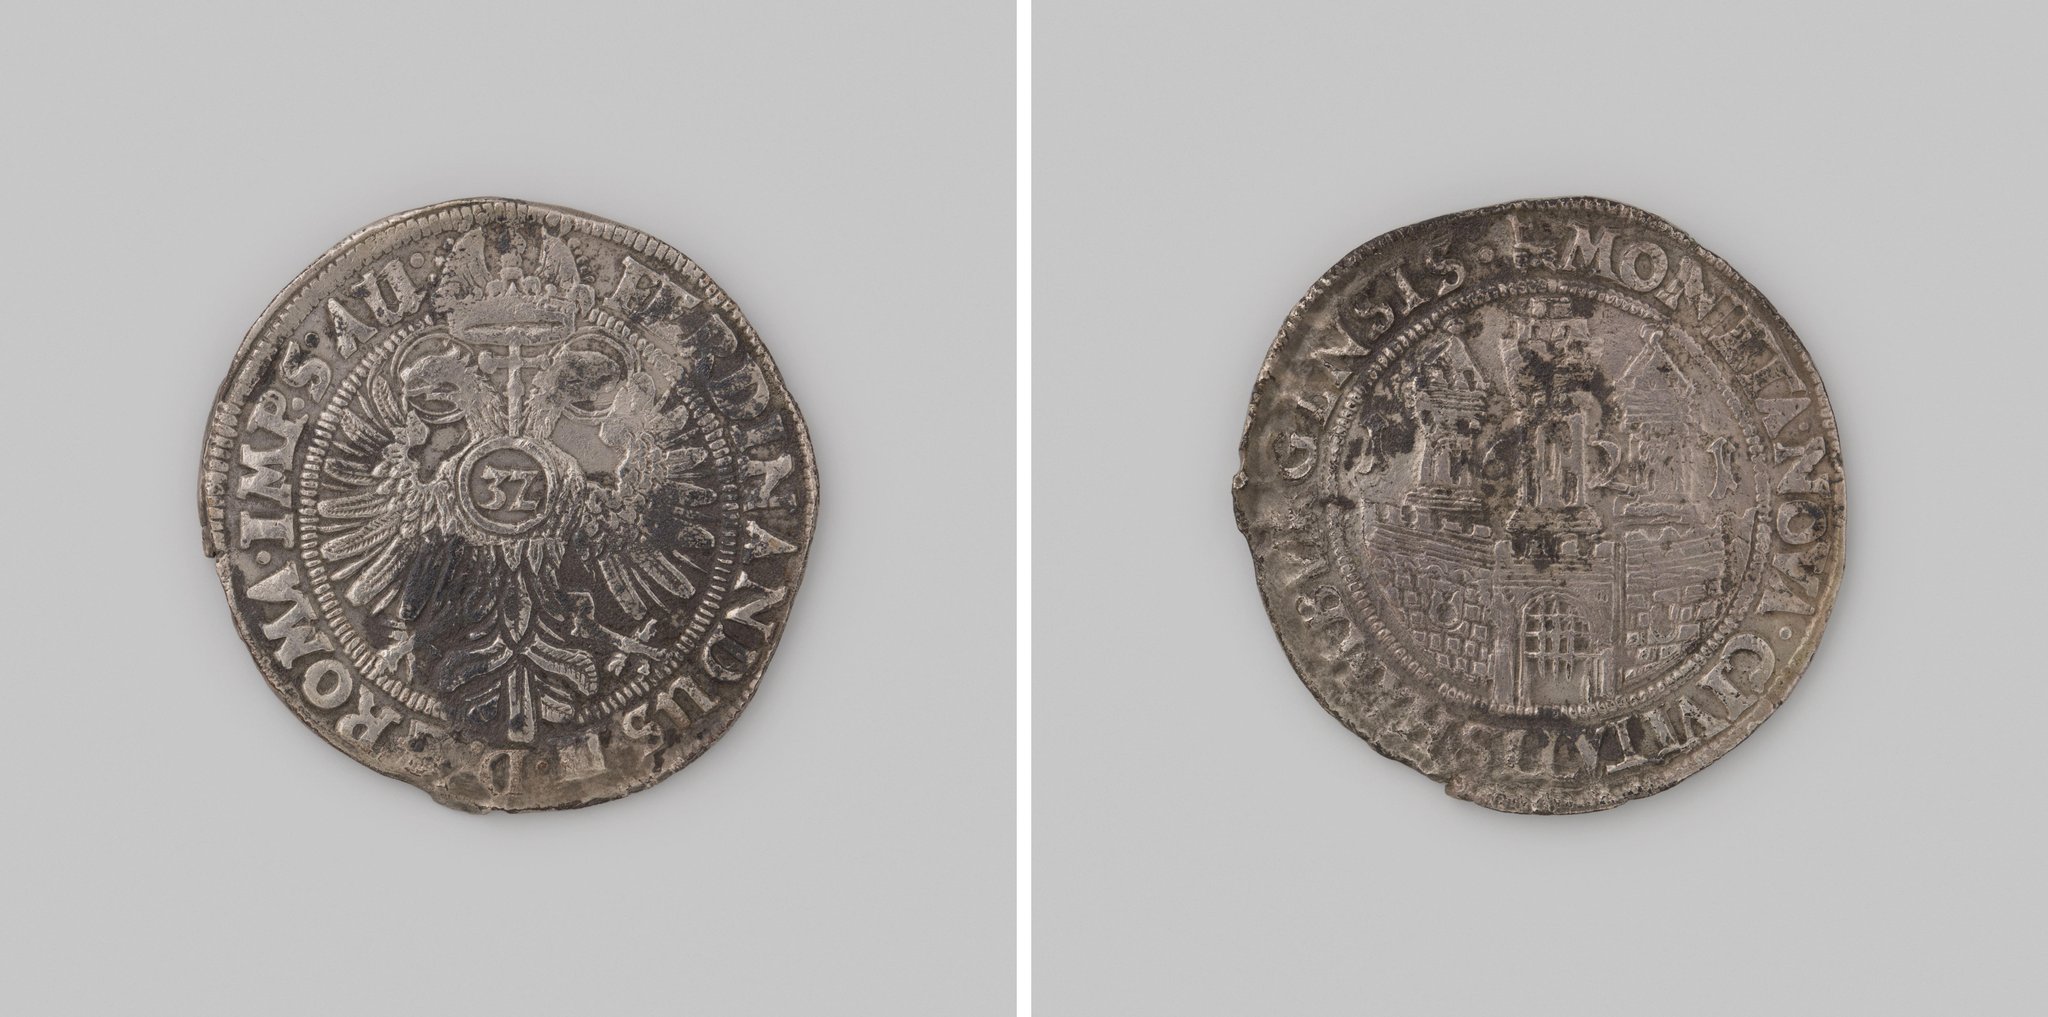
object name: coin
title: Taler van Hamburg, op naam van keizer Ferdinand II (1619-1637), afkomstig van het wrak van het VOC-schip Batavia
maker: Anonymous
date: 1621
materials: silver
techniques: striking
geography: hamburg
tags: vienna, ferdinand ii (duits keizer)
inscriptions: inscription: ‘FERDINANDUS II D G ROMA IMP S AU’, inscription: ‘MONETA NOVA CIVITATIS HAMBURGENSIS’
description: Munt met aan beide zijden opschrift tussen twee parelranden. Op de voorzijde een tweekoppige adelaar met een kruisstaf waarop een gevleugelde kroon en midden een cirkel waarop "32". Keerzijde een burcht met drie torens en een poort. Randen van de munt onregelmatig. Bijgevoegd een koperen plaatje met opschrift.